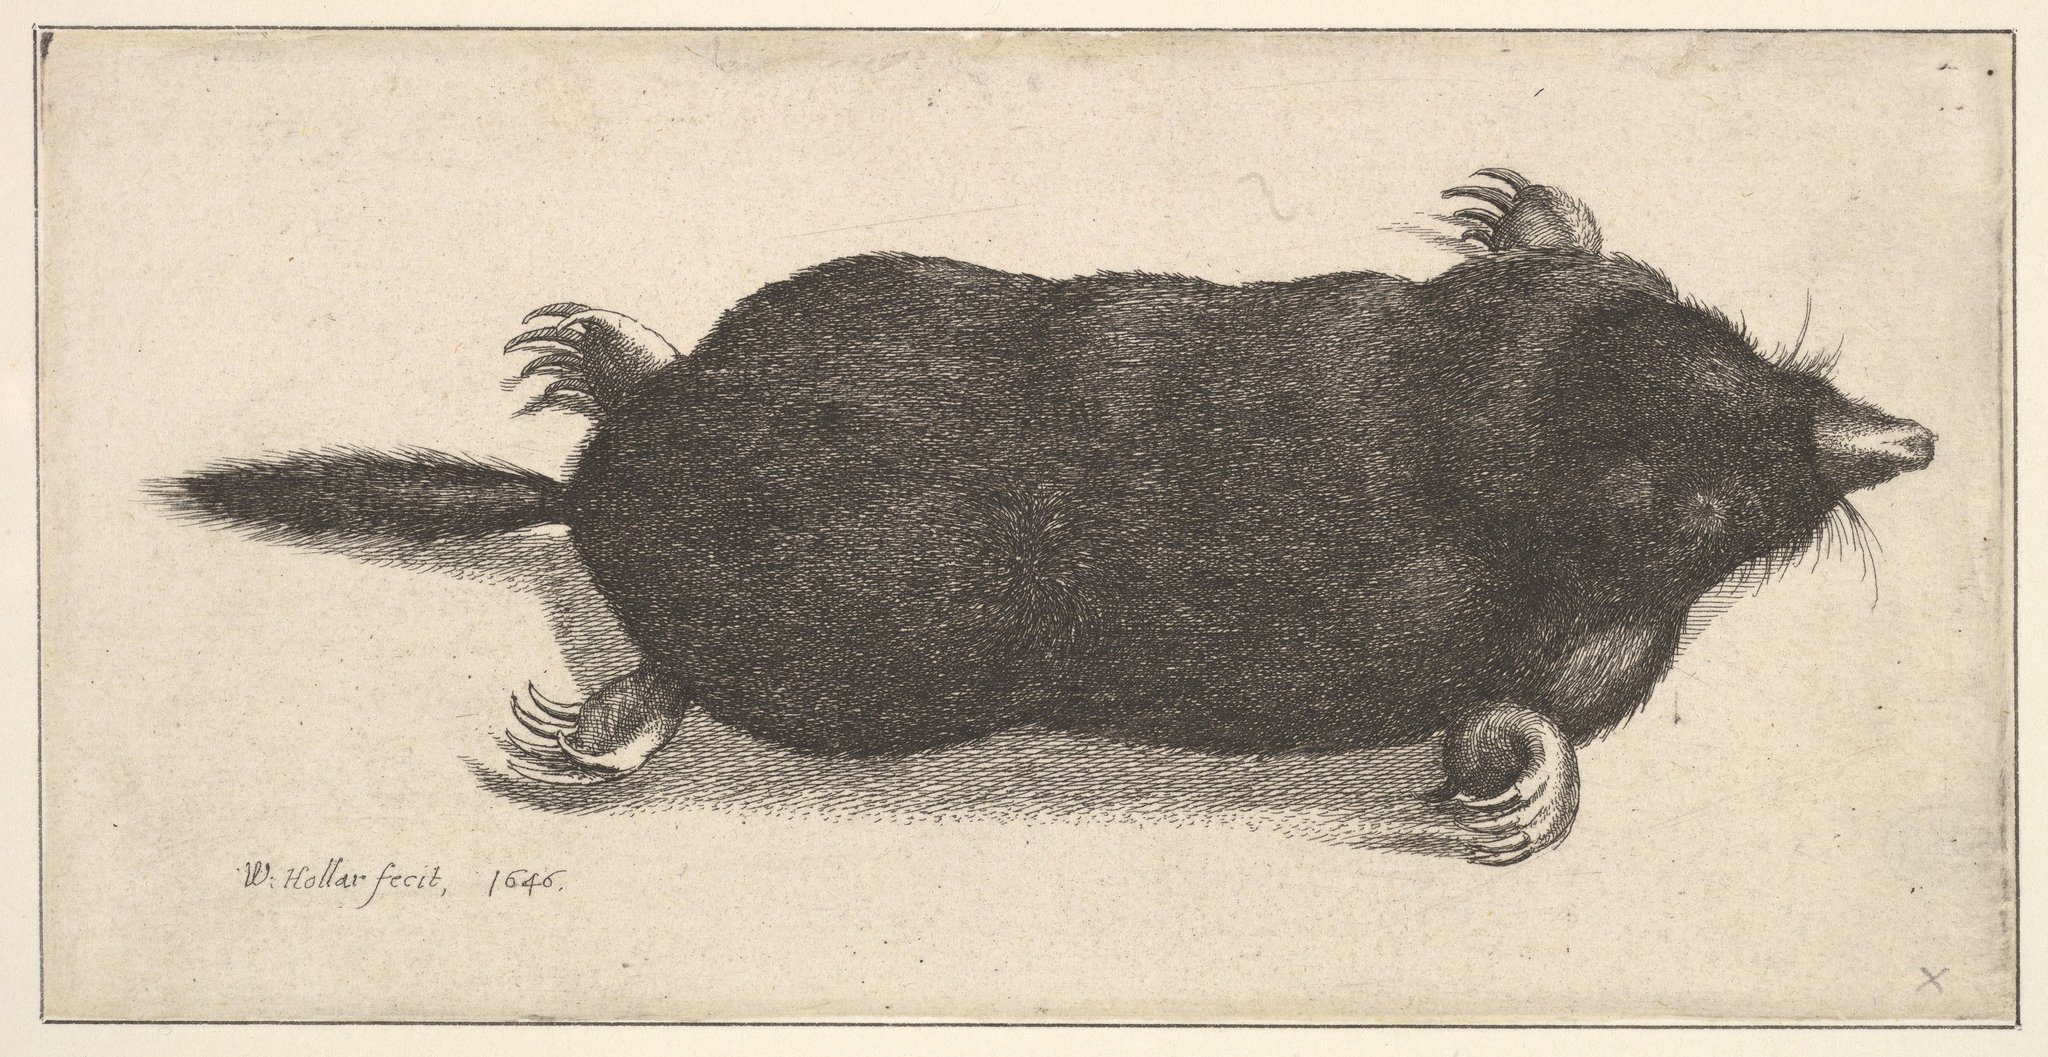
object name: print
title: Dead Mole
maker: wenceslaus hollar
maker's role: artist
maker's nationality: bohemian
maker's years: 1607-1677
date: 1646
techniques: etching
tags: animals